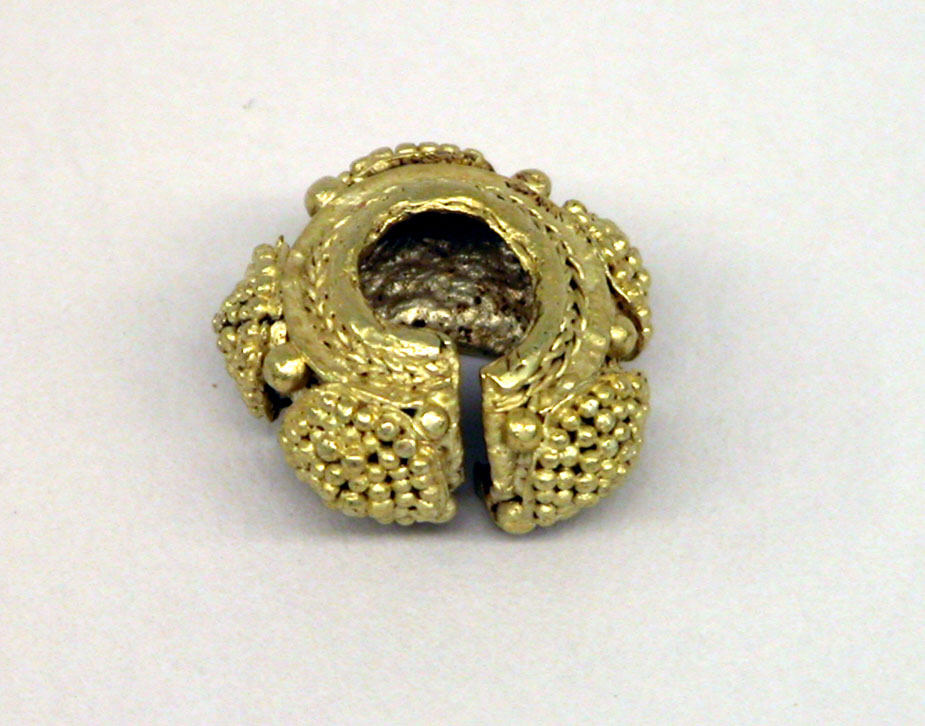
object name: ear ornament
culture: indonesian, javanese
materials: gold